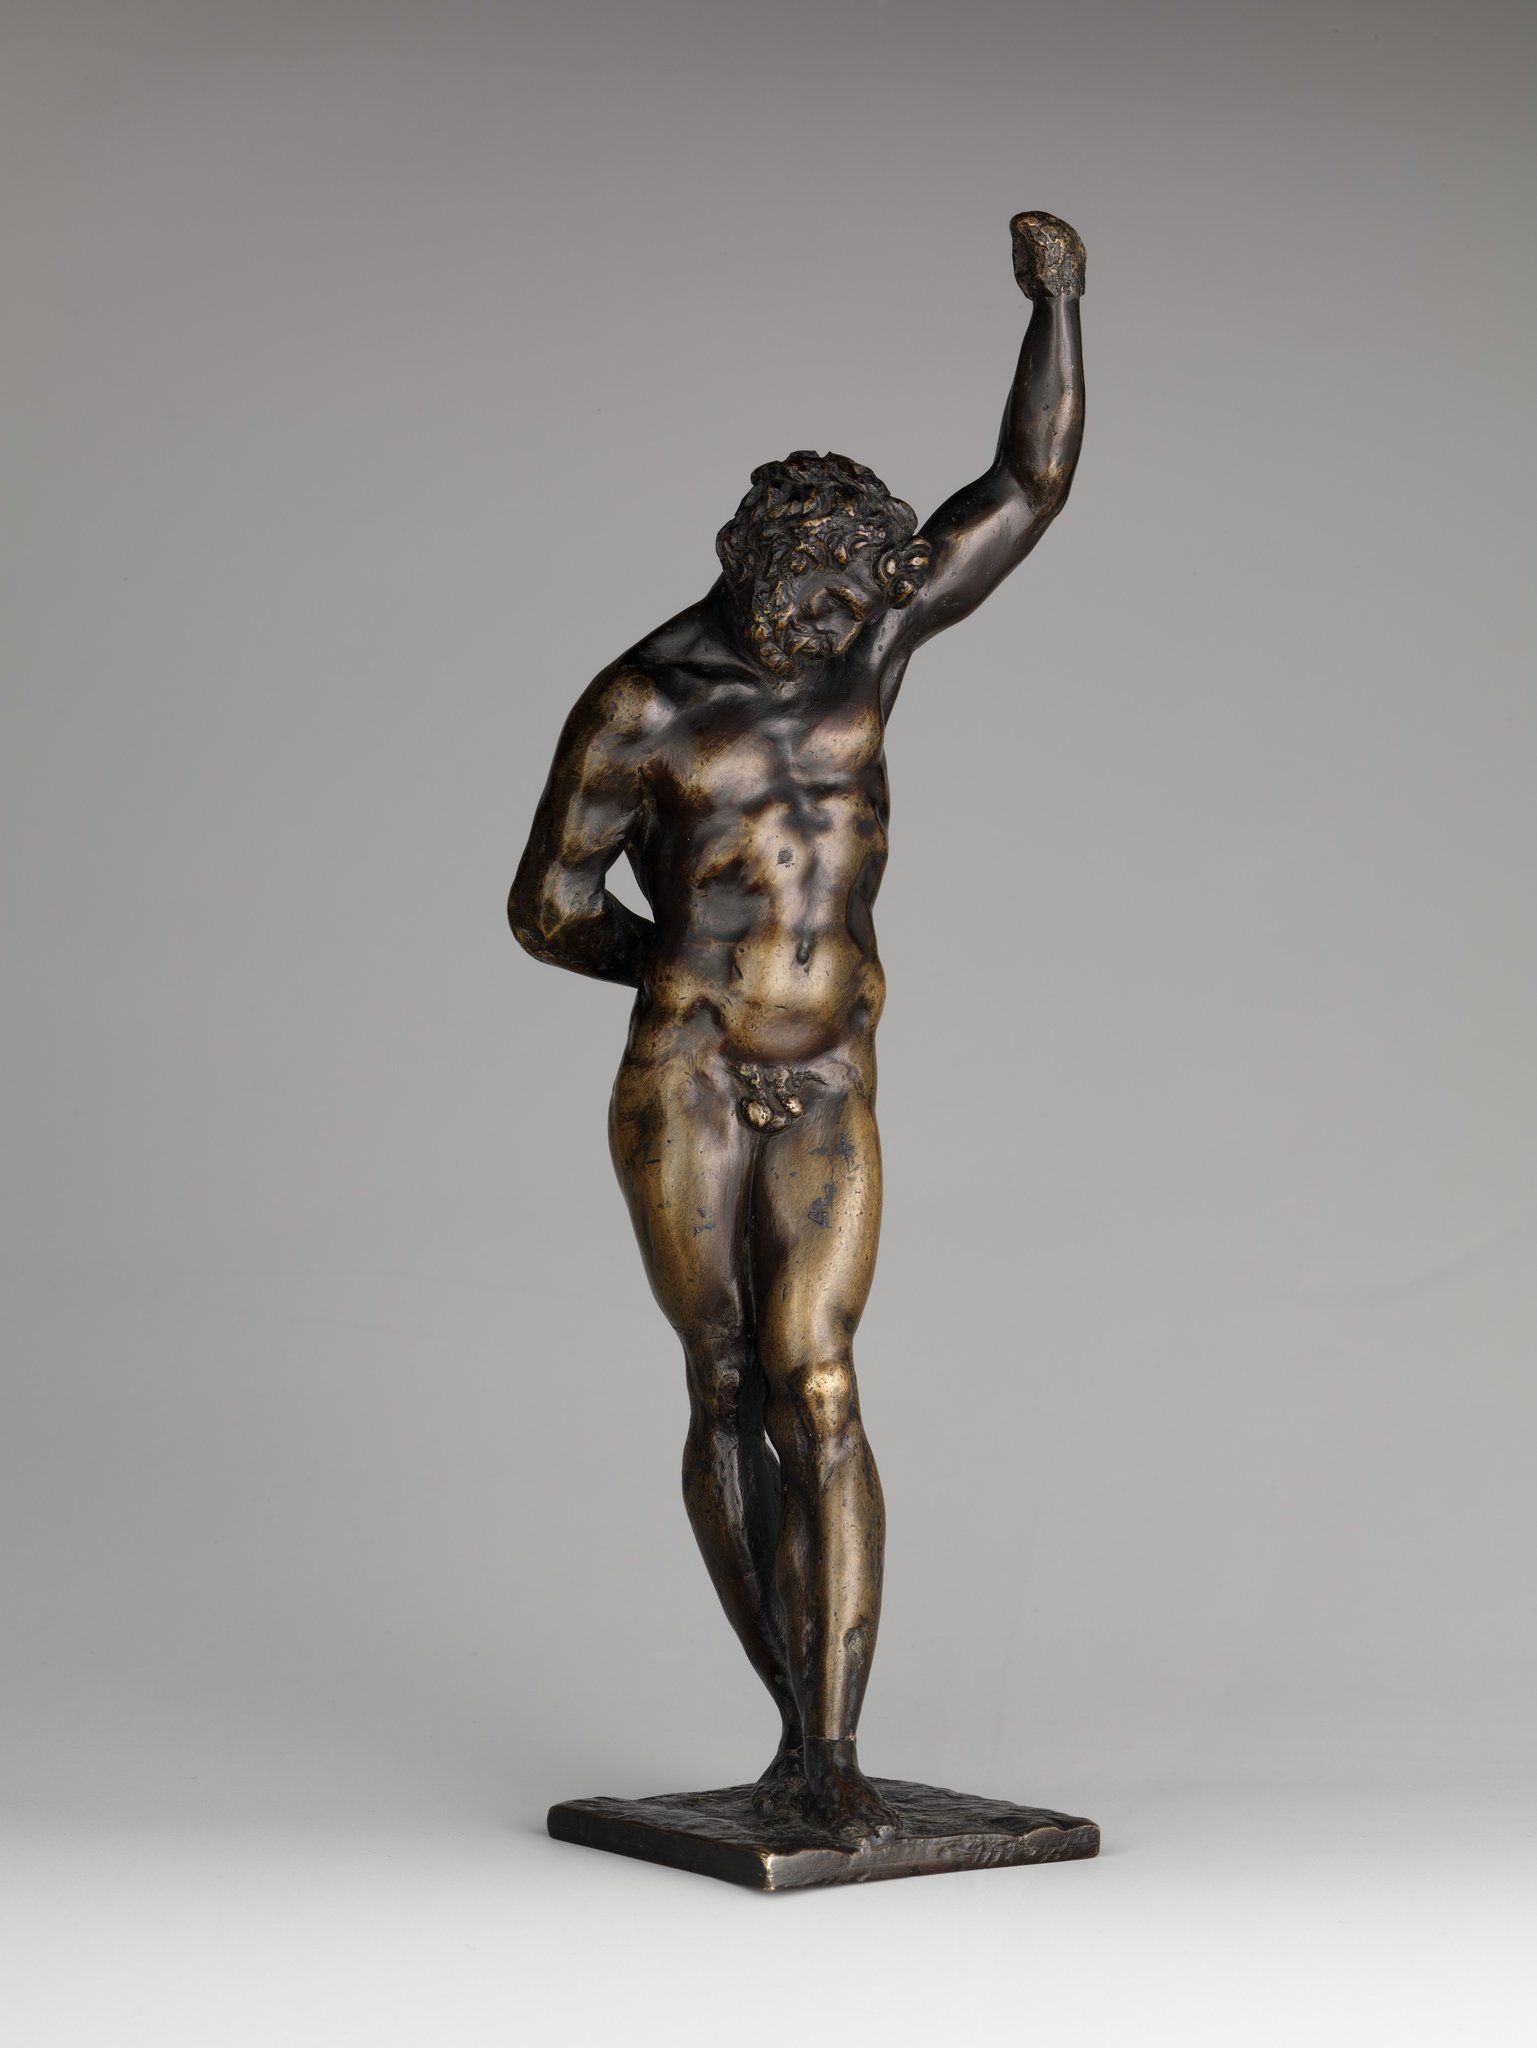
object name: statuette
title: Pluto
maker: giovanni battista di jacopo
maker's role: artist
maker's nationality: italian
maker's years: 1494-1540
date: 1634-1666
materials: bronze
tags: male nudes,pluto